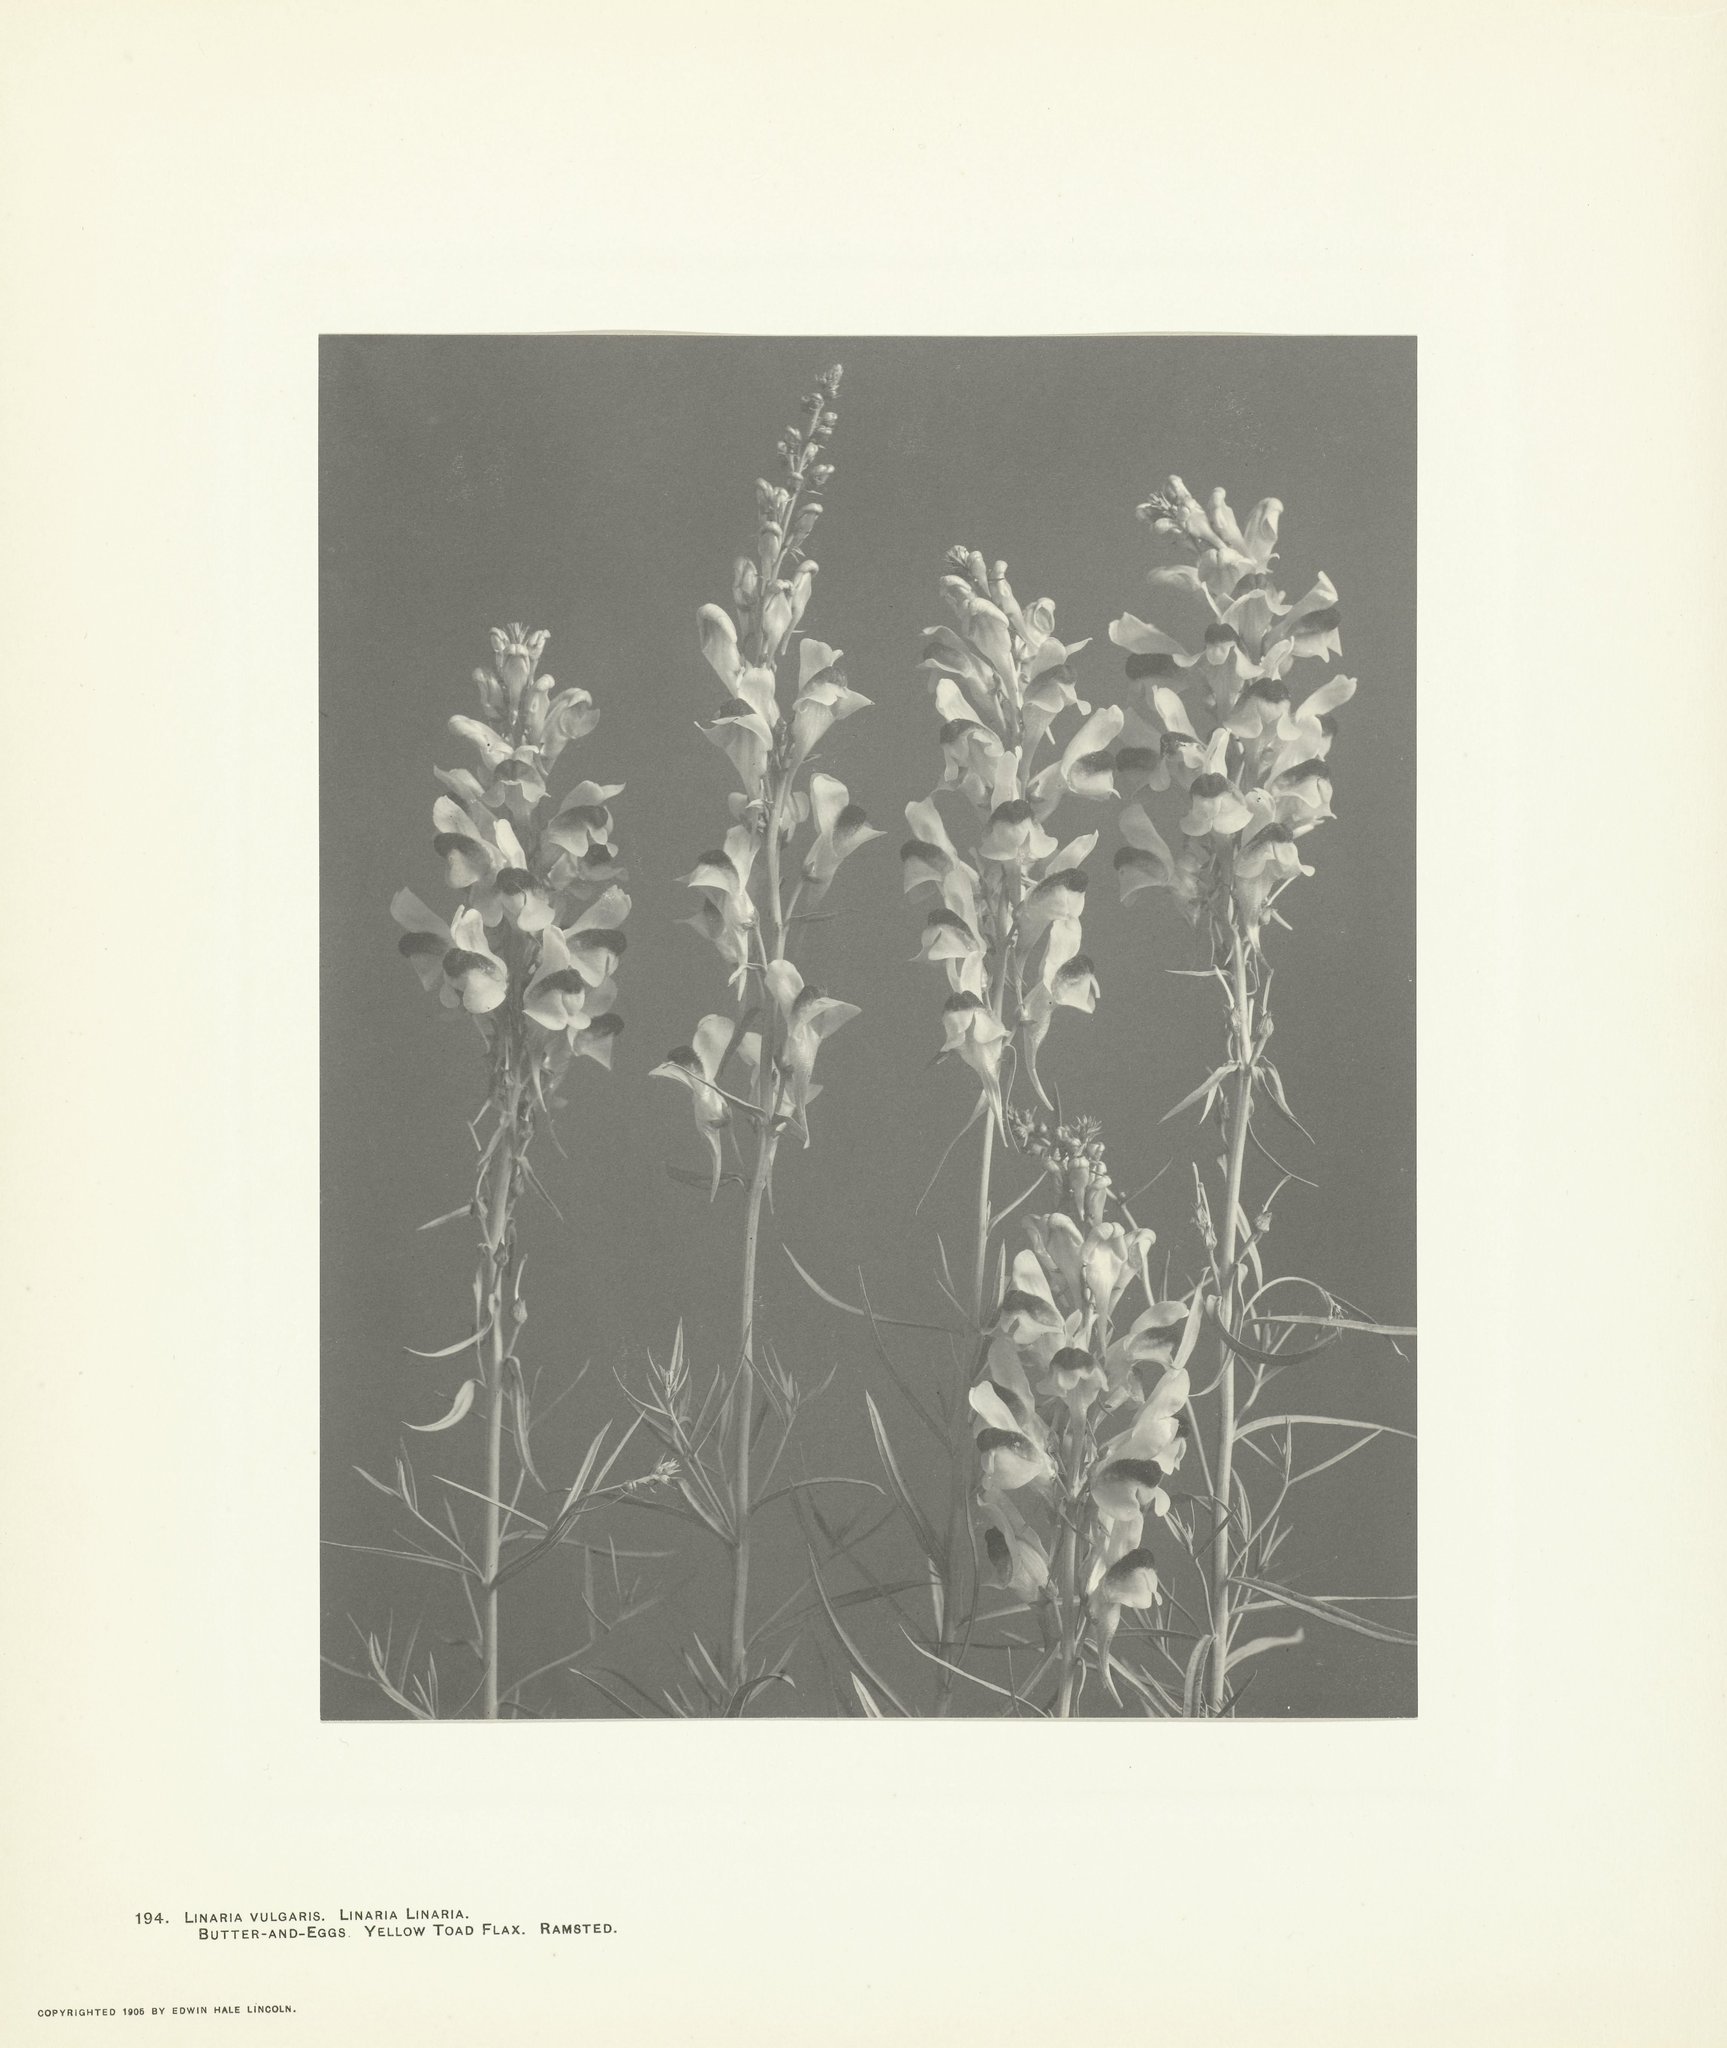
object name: photograph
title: Wild Flowers of New England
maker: edwin hale lincoln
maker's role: fotograaf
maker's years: 1848-1938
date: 1905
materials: cardboard, paper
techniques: platinum process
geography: new england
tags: flowers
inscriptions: number: ‘194.’, title: ‘LINARIA VULGARIS. LINARIA LINARIA. / BUTTER-AND-EGGS. YELLOW TOAD FLAX. RAMSTED.’, copyright notice: ‘COPYRIGHTED 1905 BY EDWIN HALE LINCOLN.’